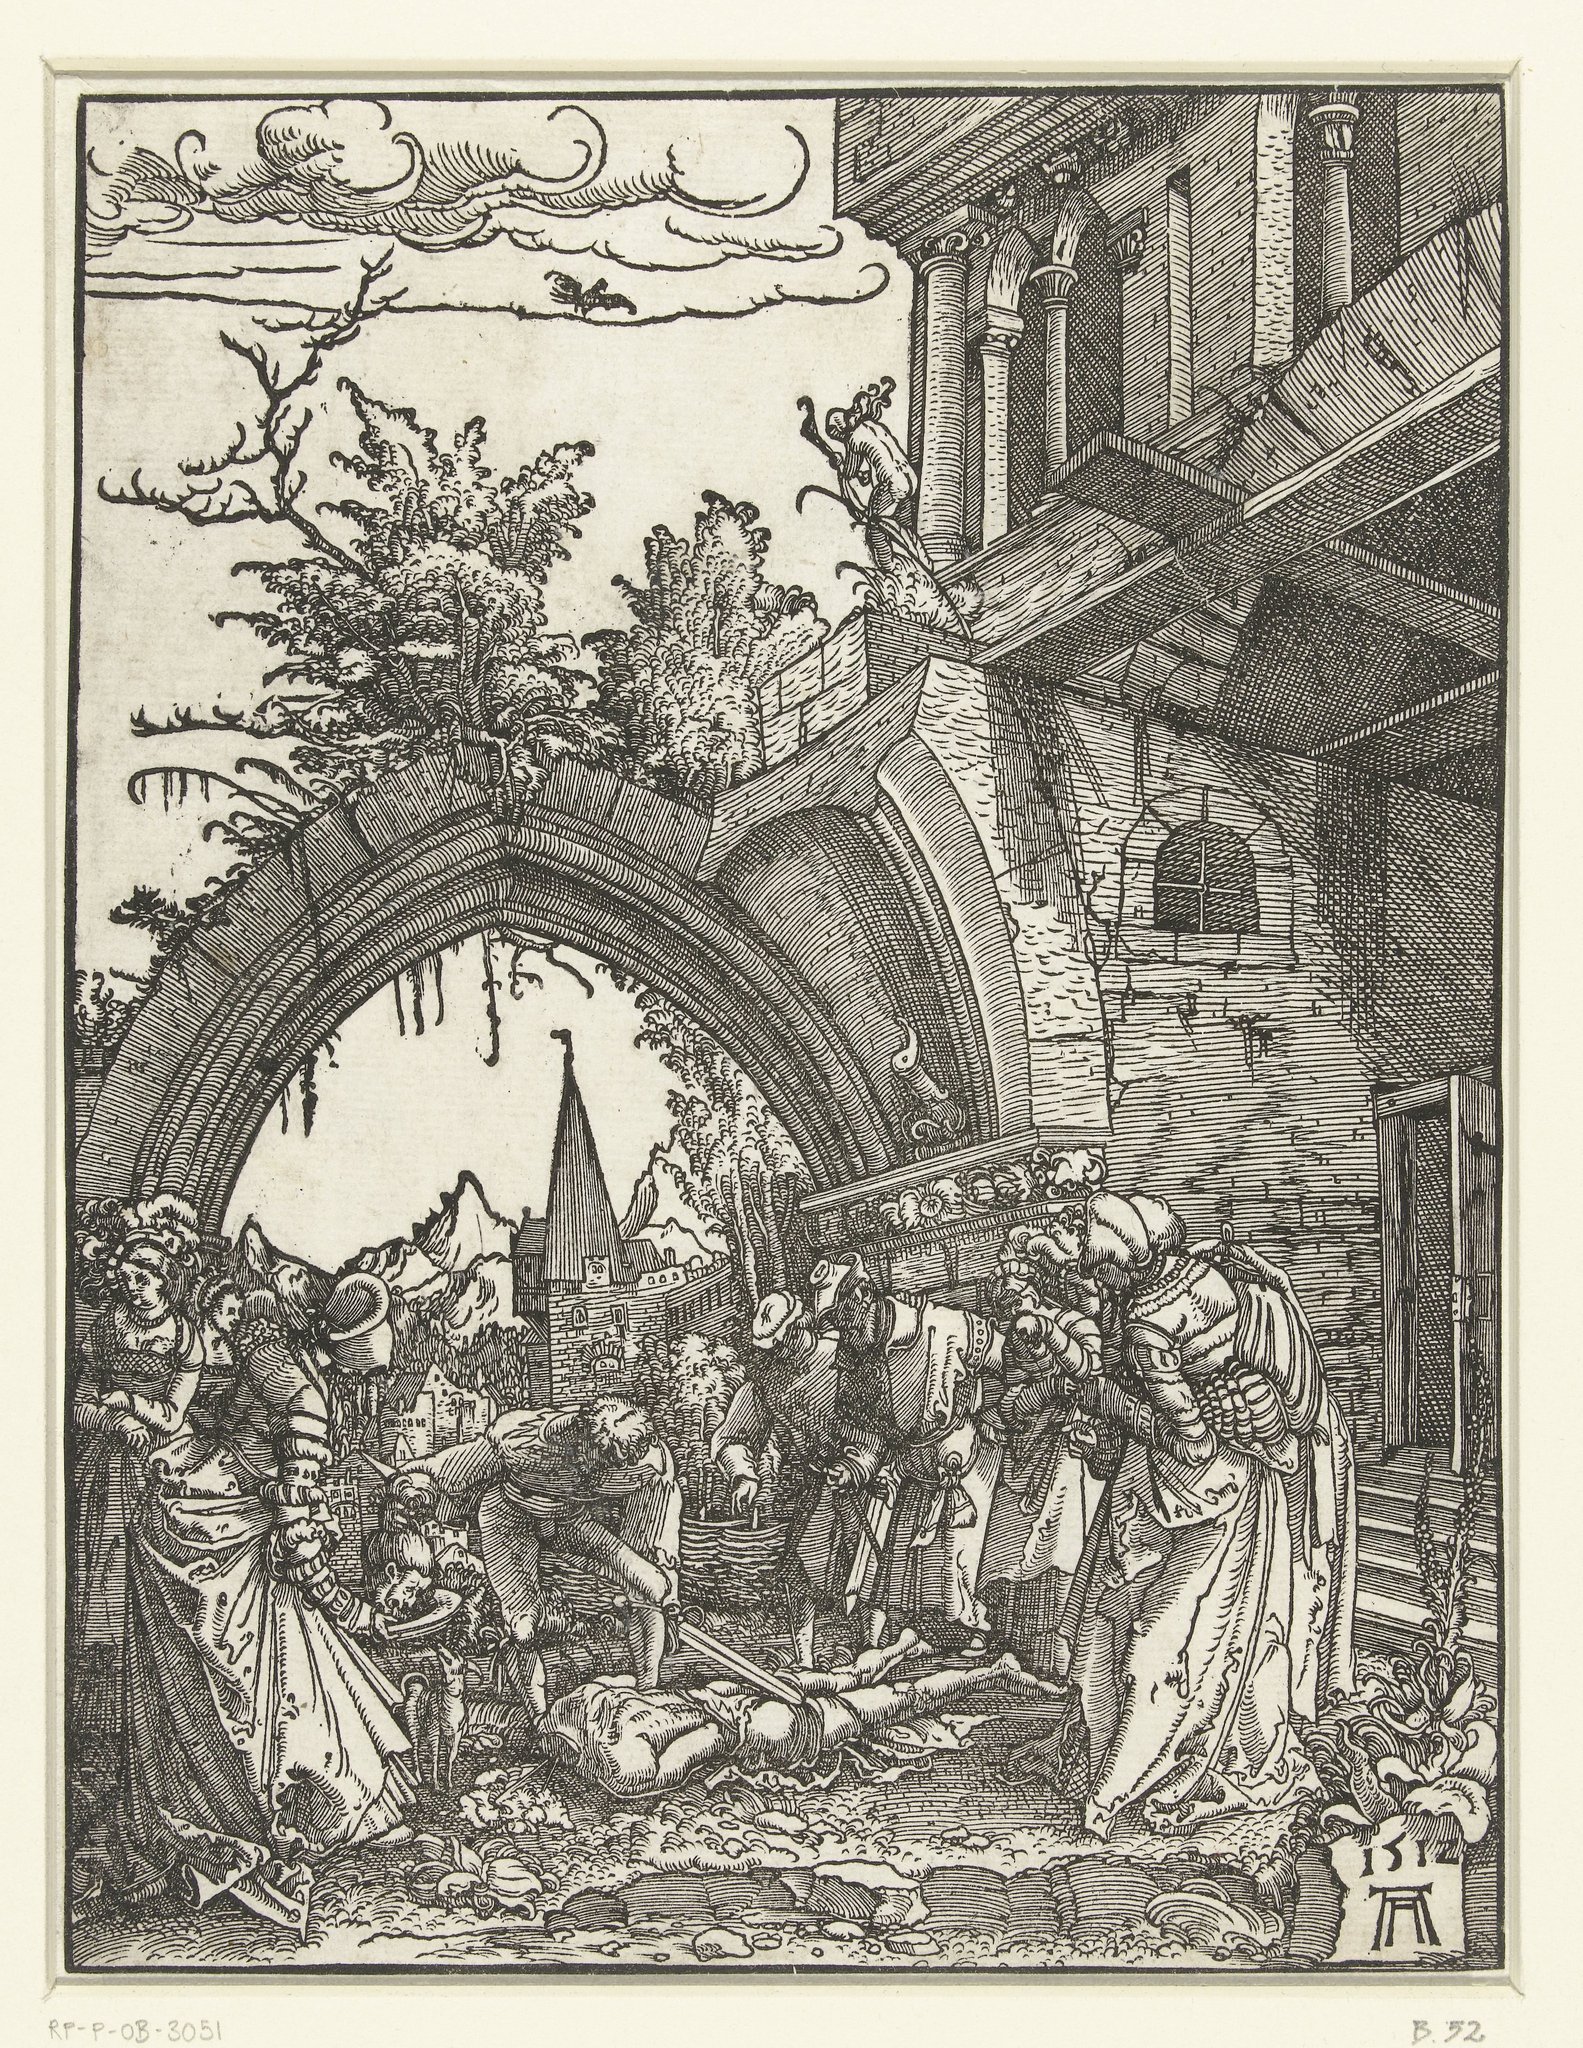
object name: print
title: Onthoofding van Johannes de Doper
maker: albrecht altdorfer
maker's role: draughtsman, print maker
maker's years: 1480-1538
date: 1512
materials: paper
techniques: woodcut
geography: germany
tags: the beheading of john the baptist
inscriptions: number: ‘78’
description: De beul met een zwaard staand bij het lichaam van Johannes de Doper. Hij legt het afgehakte hoofd op een schaal welke wordt vastgehouden door een vrouw. Een groepje mannen en vrouwen staat toe te kijken.